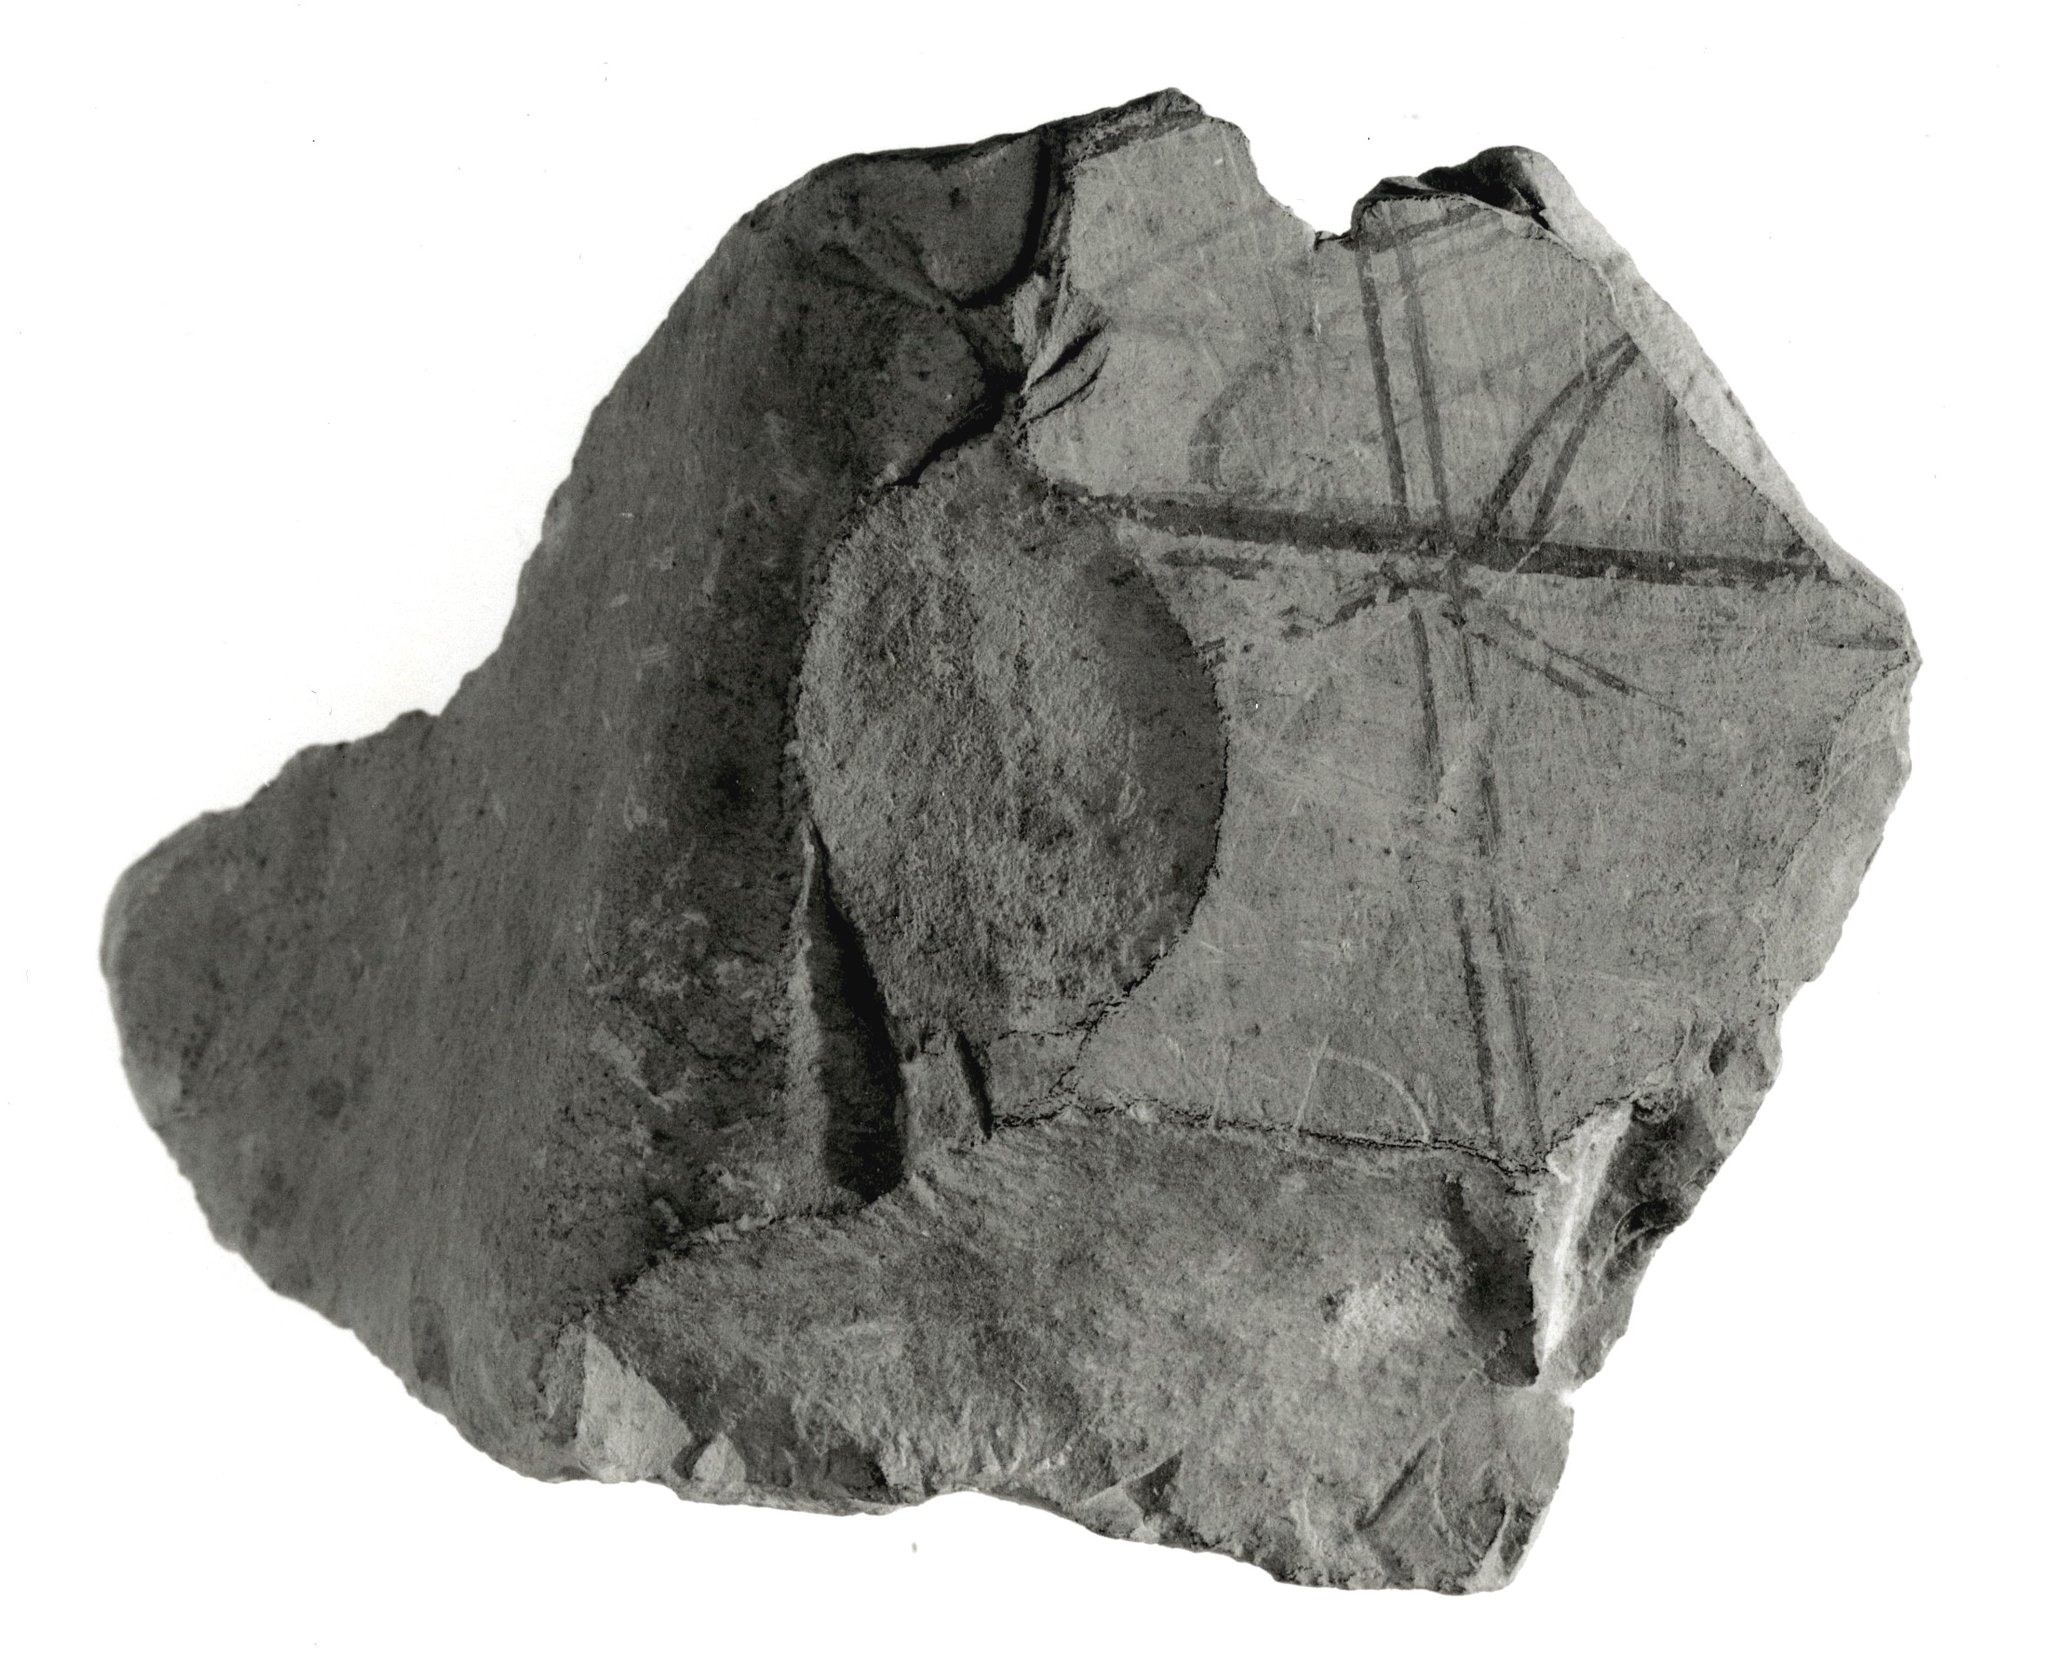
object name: relief, tomb of nespekashuty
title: Drawing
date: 664-610 BCE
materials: limestone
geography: egypt